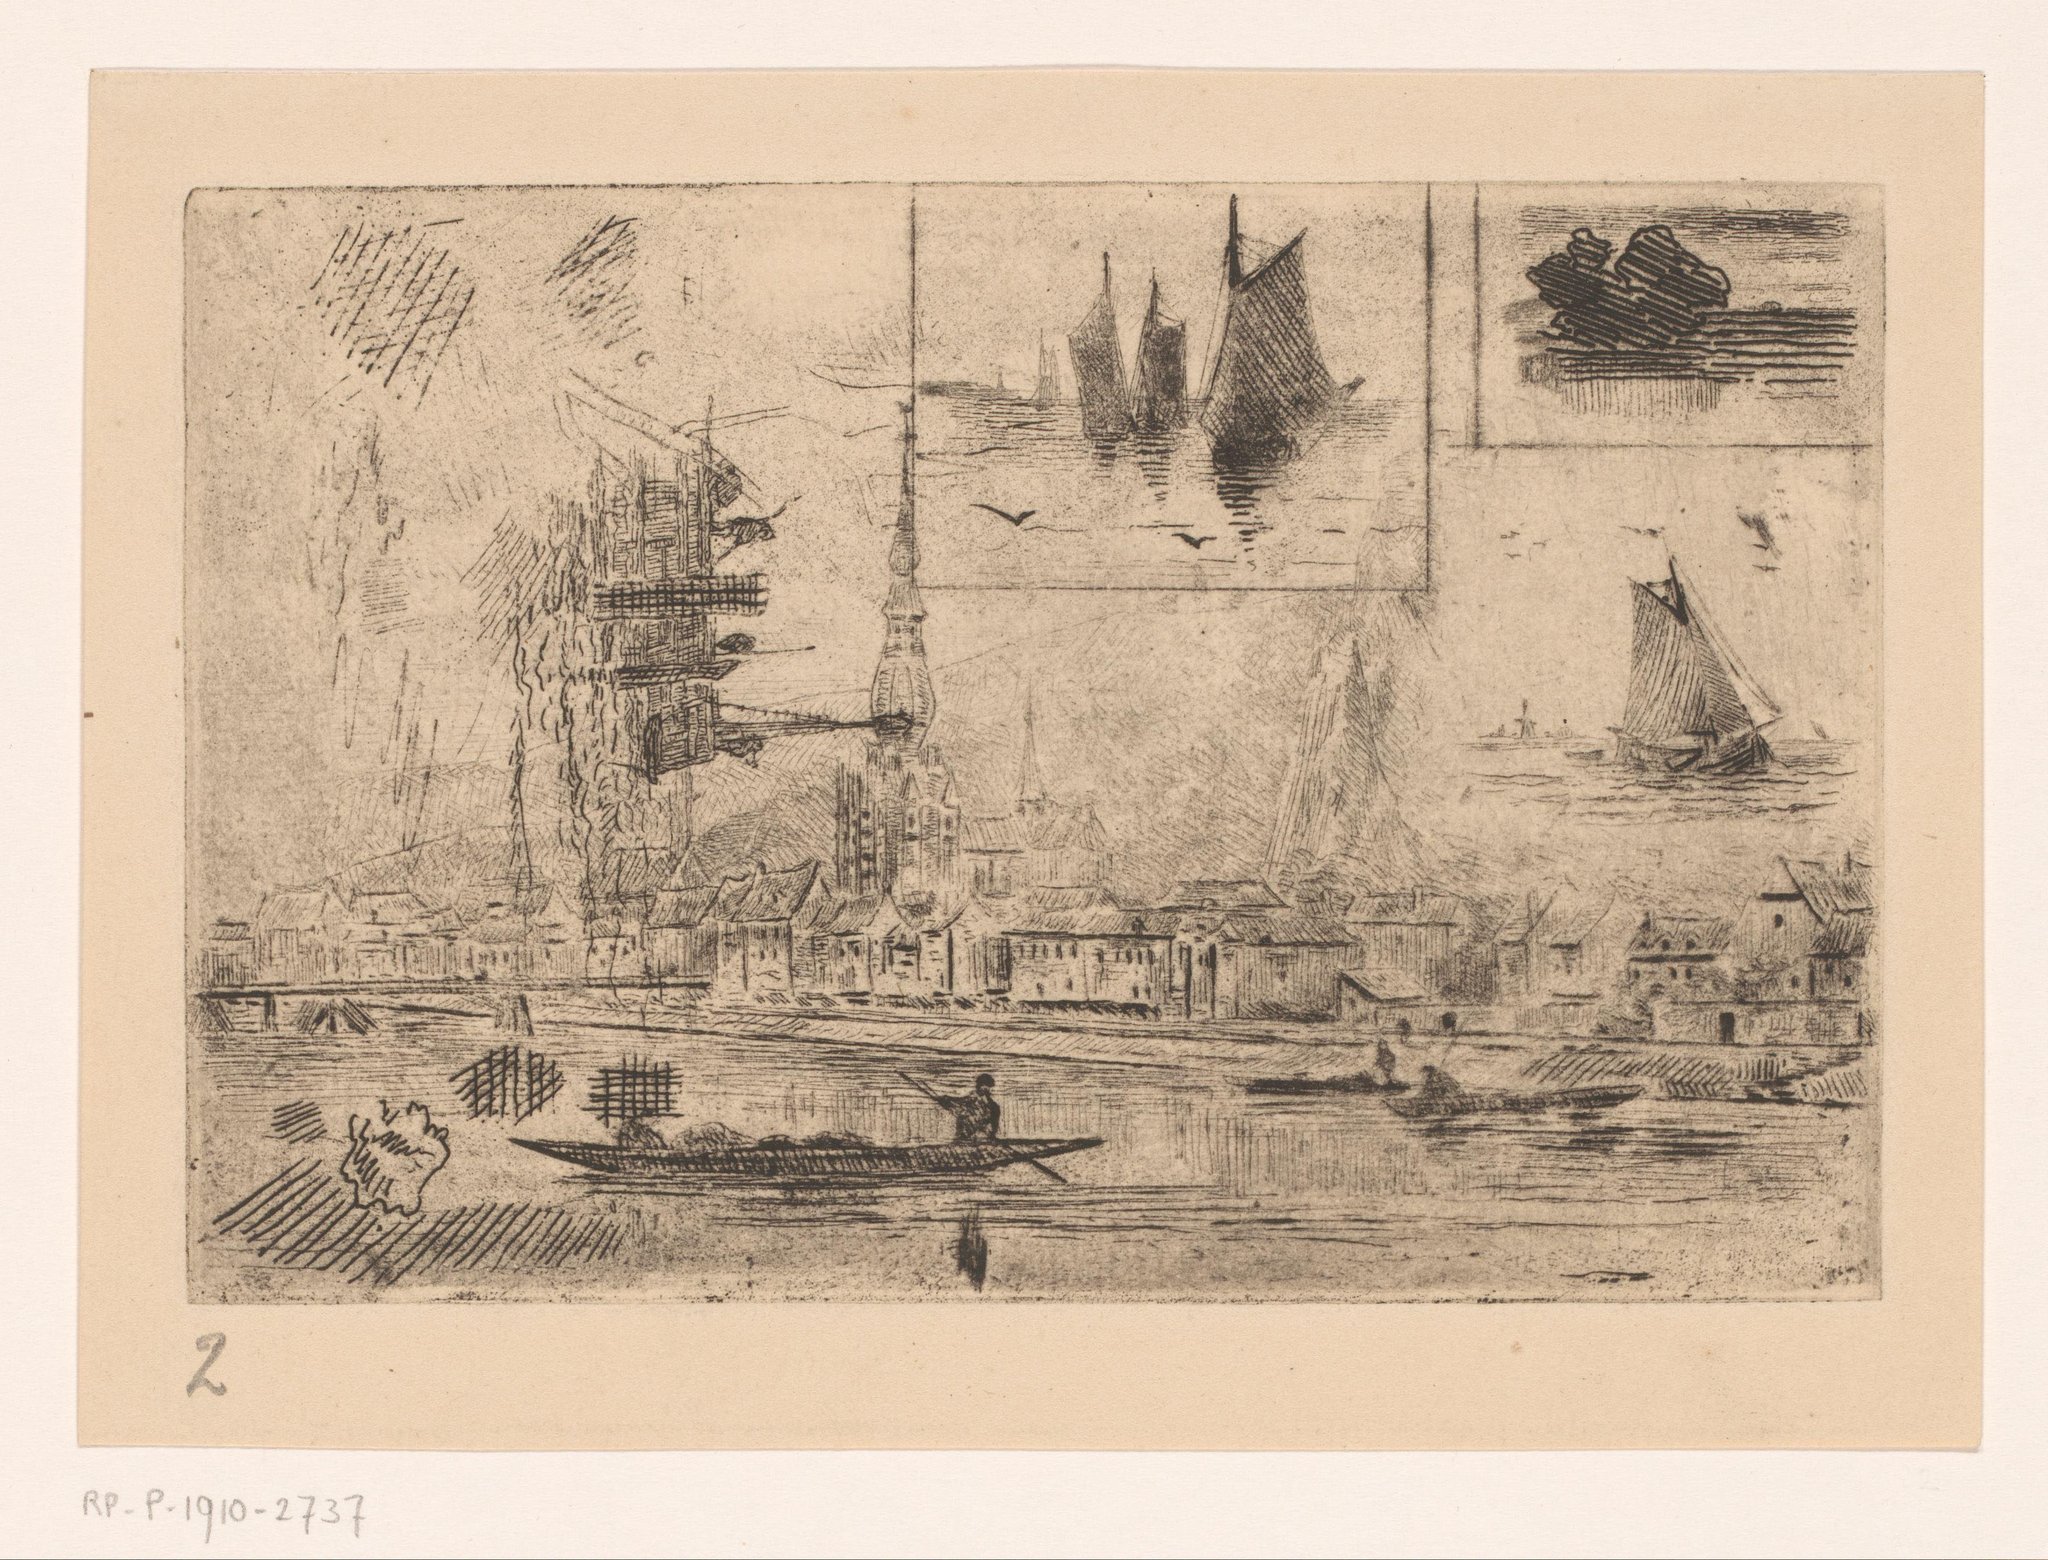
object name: print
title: Vue de Dinant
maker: carel nicolaas storm van s-gravesande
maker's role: draughtsman, print maker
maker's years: 1841-1924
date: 1871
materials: paper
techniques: drypoint, etching, intaglio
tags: city-view in general; 'veduta', church (exterior), sea (seascape)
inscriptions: collector's mark: Lugt 2228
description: Gezicht op Dinant met op de voorgrond een gondel op de Maas. In het midden is de toren van de Collegiale kerk Onze-Lieve-Vrouw van Dinant te zien. Rechtsboven drie voorstellingen van zeegezichten met zeilschepen.